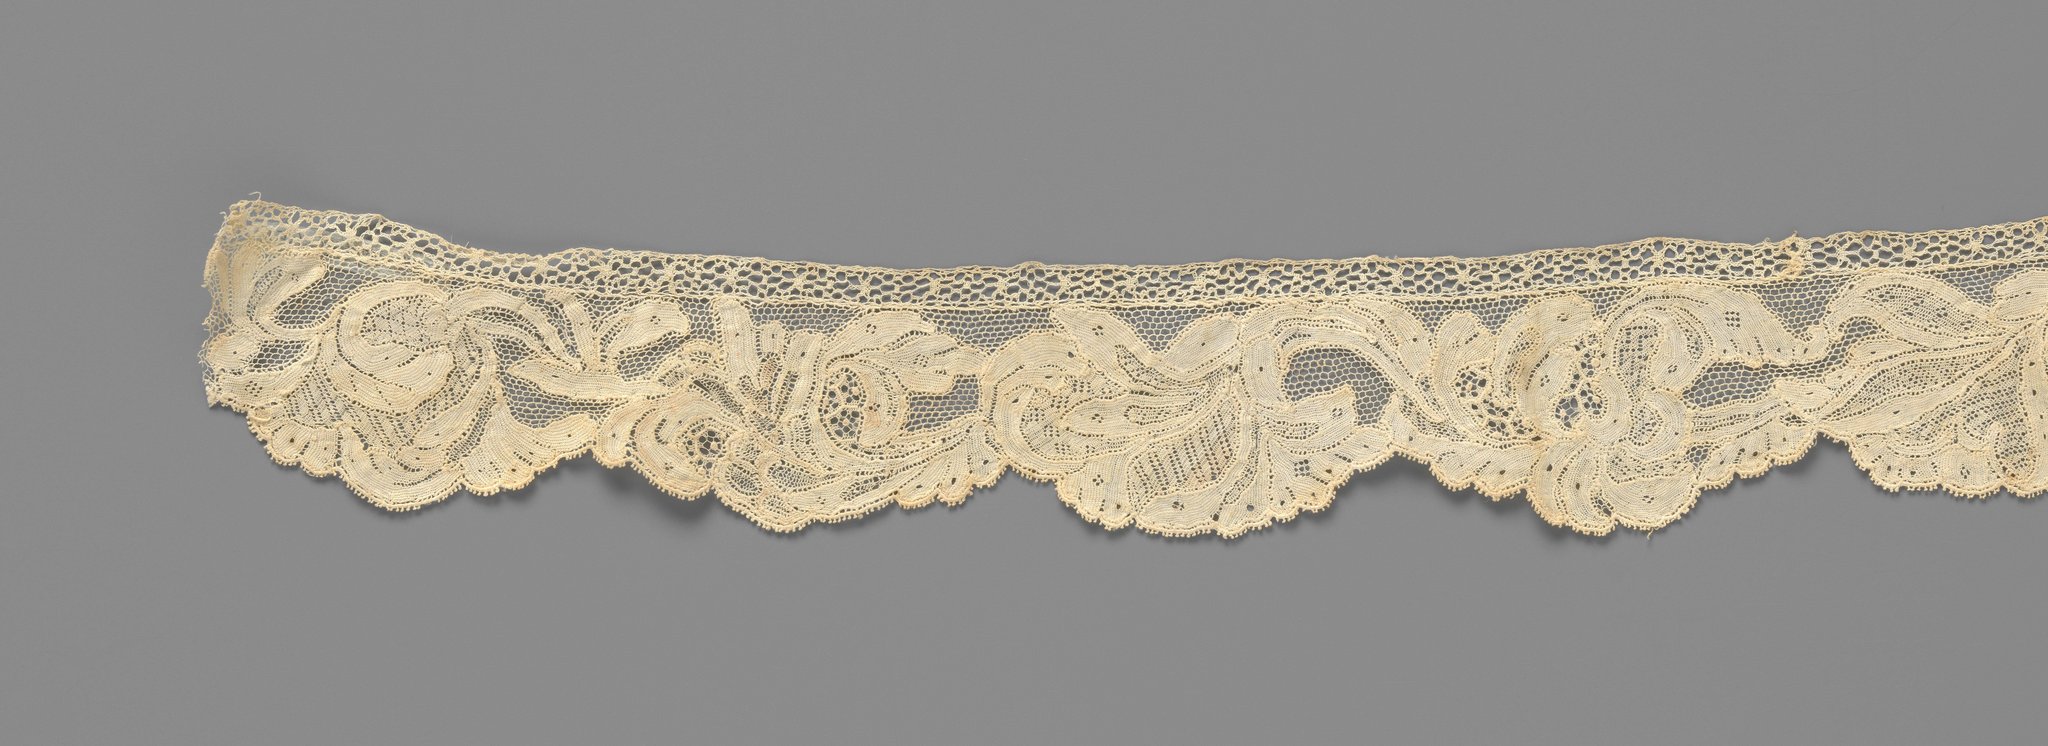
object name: engageante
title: Engageante van naaldkant met een symmetrisch patroon met een bloemenvaas ranken waaraan gevederde bladeren en irissen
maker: Anonymous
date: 1725-1749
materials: linen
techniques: lace, needlepoint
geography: italy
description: Engageante van naturelkleurige naaldkant: platte Venetiaanse netgrondkant (?). Het patroon heeft een vaas met symmetrisch geschikte bloemen, geflankeerd door twee toegewende lopende ranken, waaraan grote bloemen met "huis in huis"-werk. Het patroon heeft bovendien een iris geflankeerd door trosbloemen. De motieven zijn gemaakt met ongedraaide festonsteken waartussen talloze fijne uitsparingen zijn gemaakt. Er is een iets dikkere, maar evenzeer fijne contourdraad gebruikt om patroondelen te accentueren. De motieven zijn met elkaar verbonden door een fijne maasgrond met overdwarse toeren. In en om de meeste bloemen en bladeren zijn zeer fijne siergronden toegepast in vele varianten, waaronder siergronden met ruitjes, 'patrijsogen', blokjes en zigzag-lijnen. De schulpenrand komt voort uit het patroon en is afgewerkt met picots. De bovenzijde is recht en afgewerkt met een geklost bandje. Aan de linkerzijde is de engageante verlengt met een strookje van hetzelfde type kant.